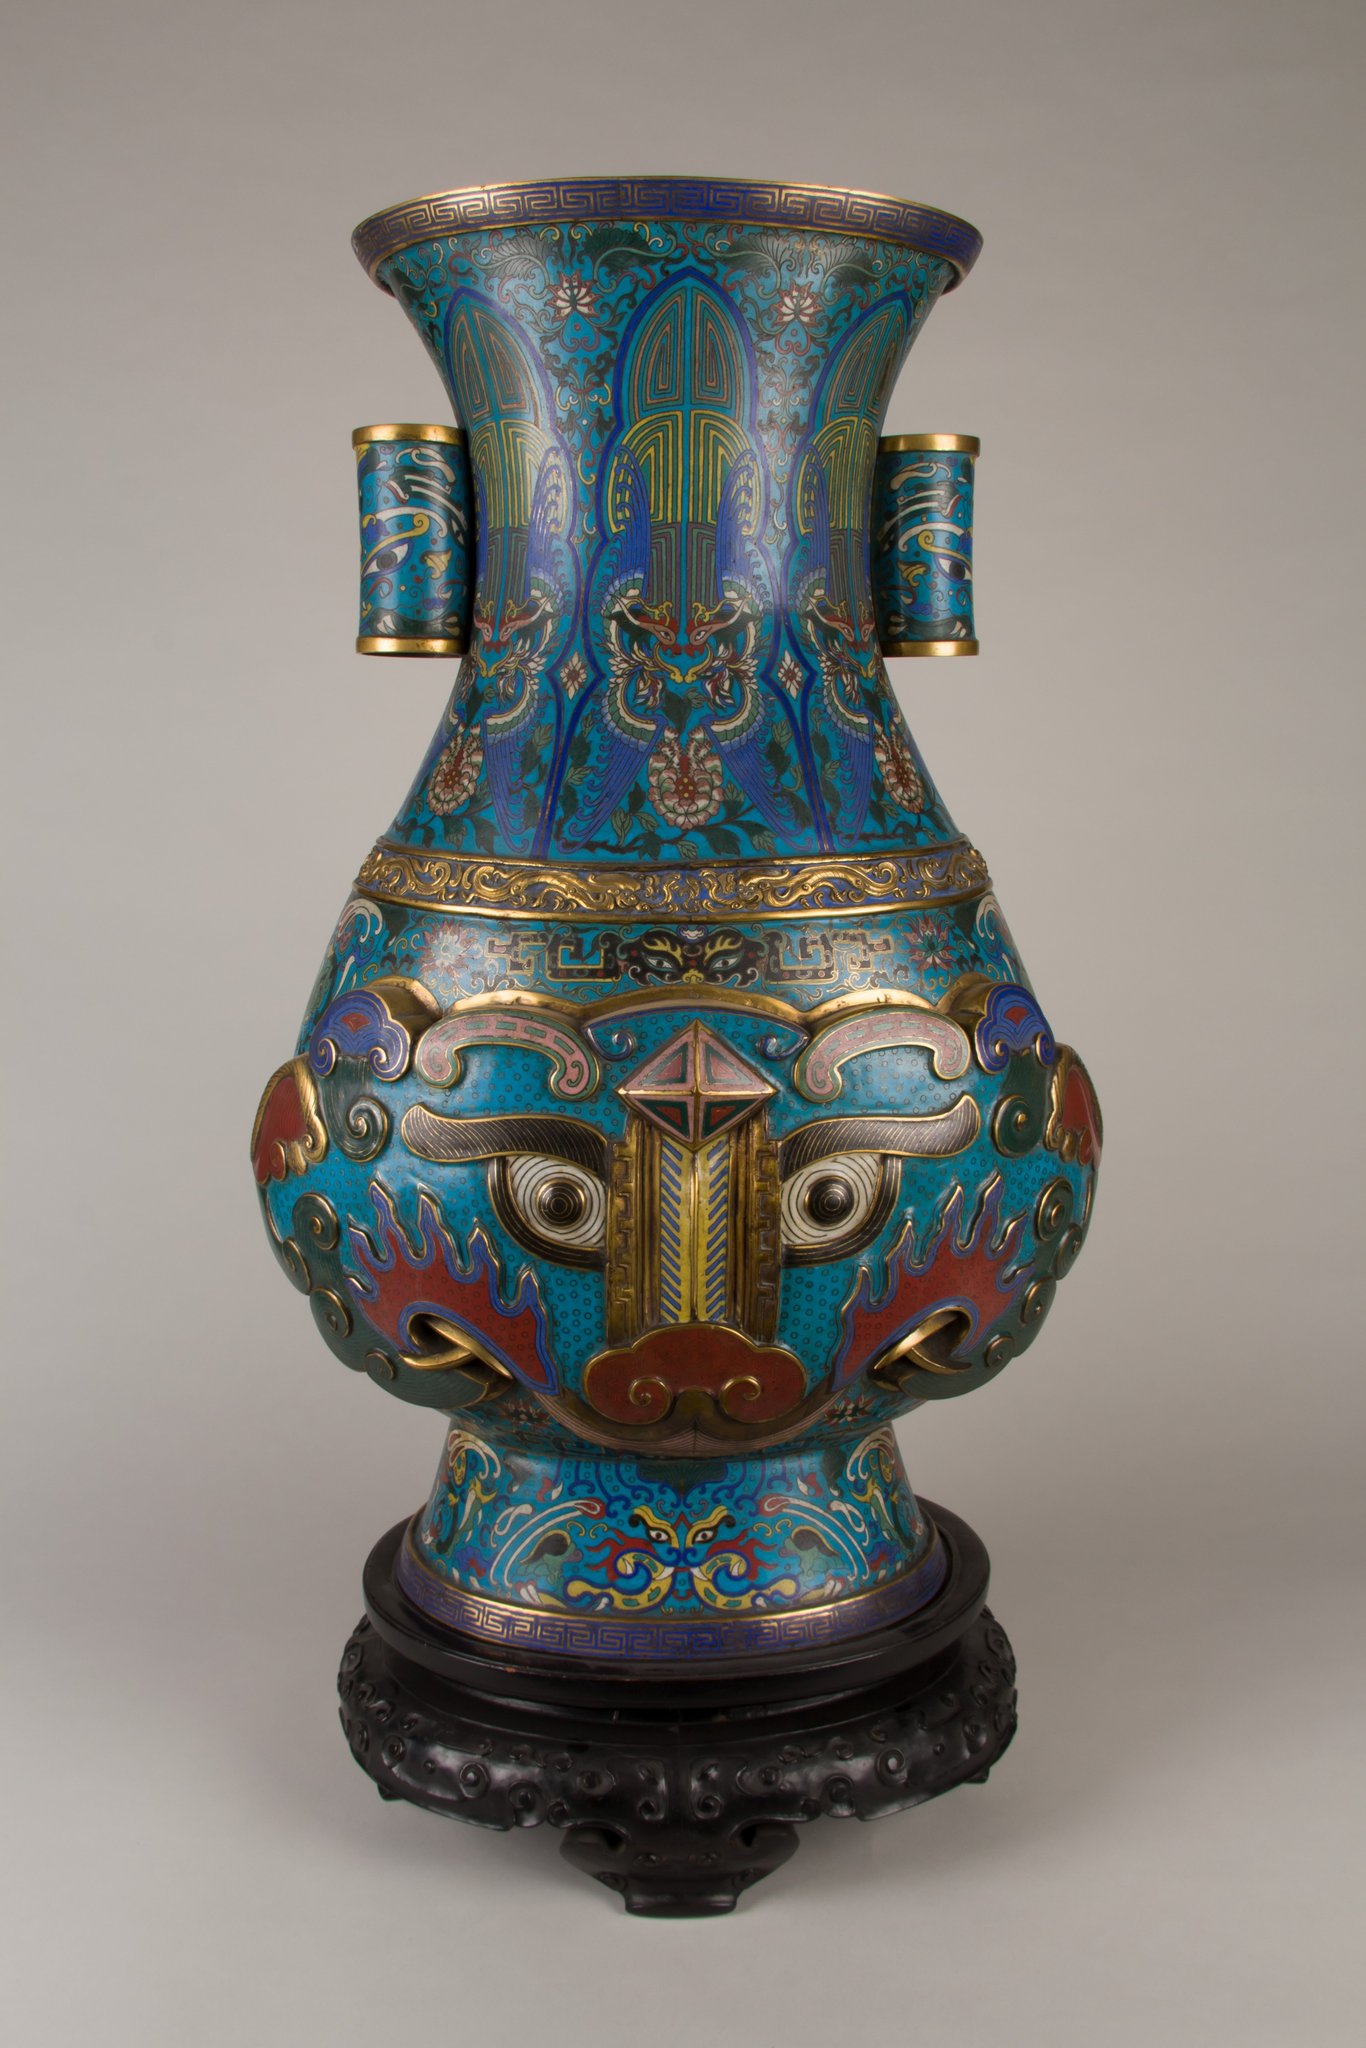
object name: vase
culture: chinese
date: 1801-1900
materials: enamel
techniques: enamel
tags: eyes